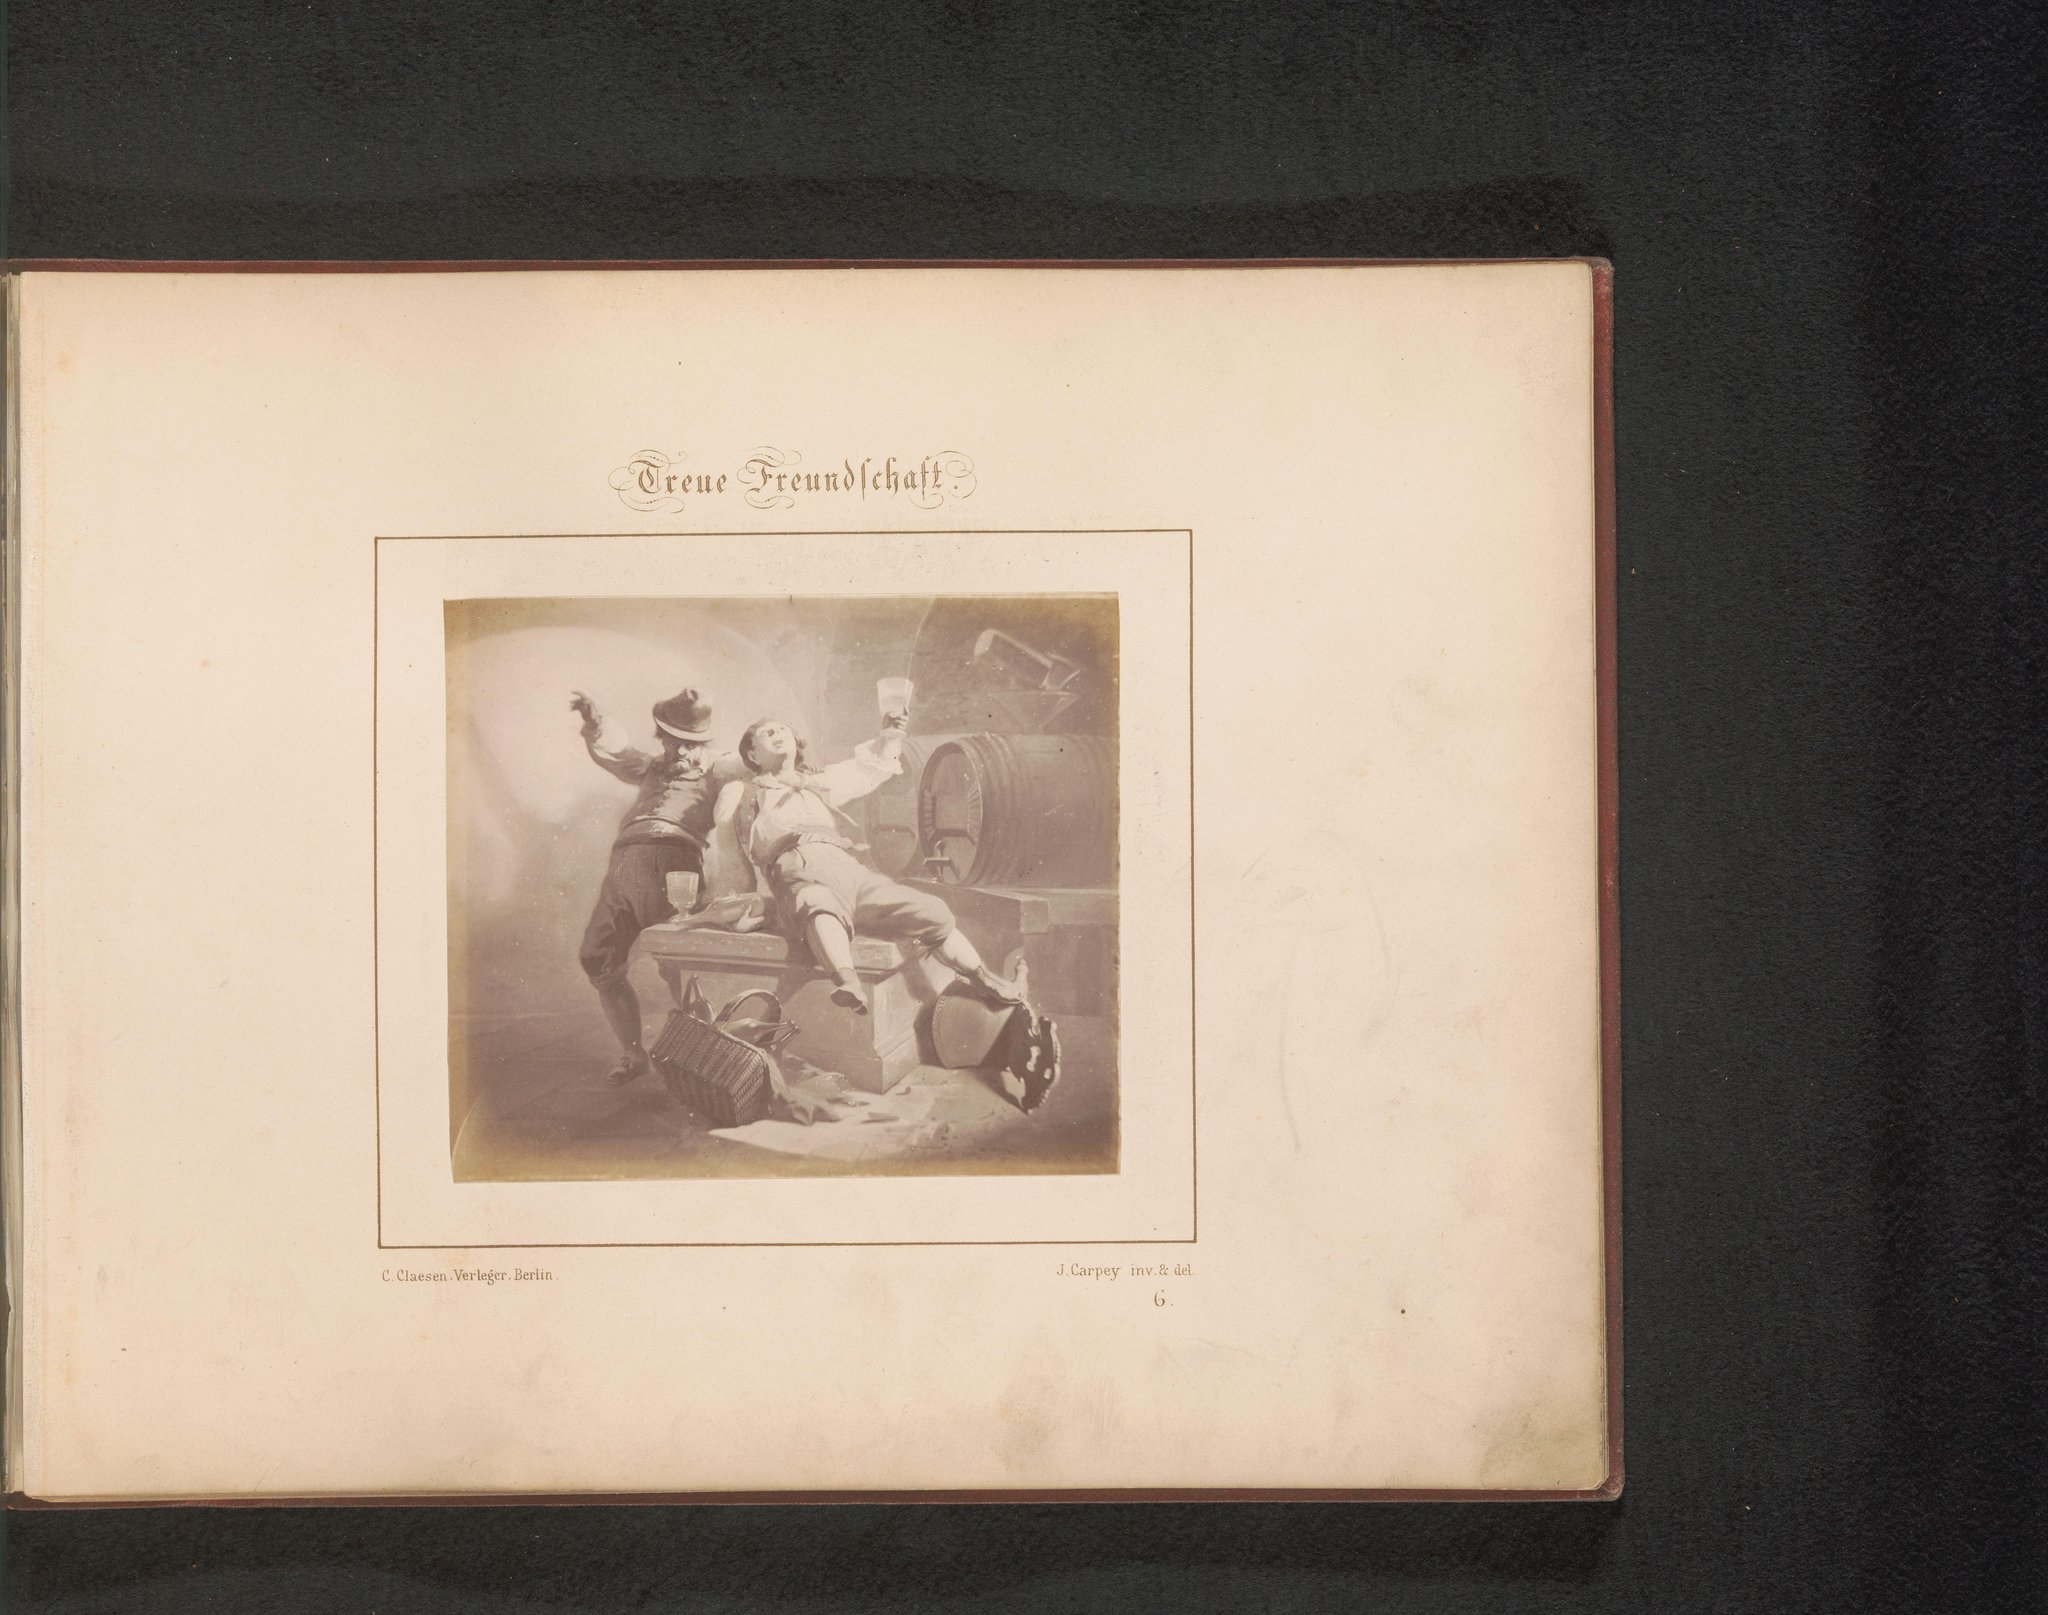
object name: page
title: Treue Freundschaft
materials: photographic support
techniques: albumen print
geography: berlin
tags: adult man, wine ~ alcoholic drinks, drunkenness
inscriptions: number: ‘6.’